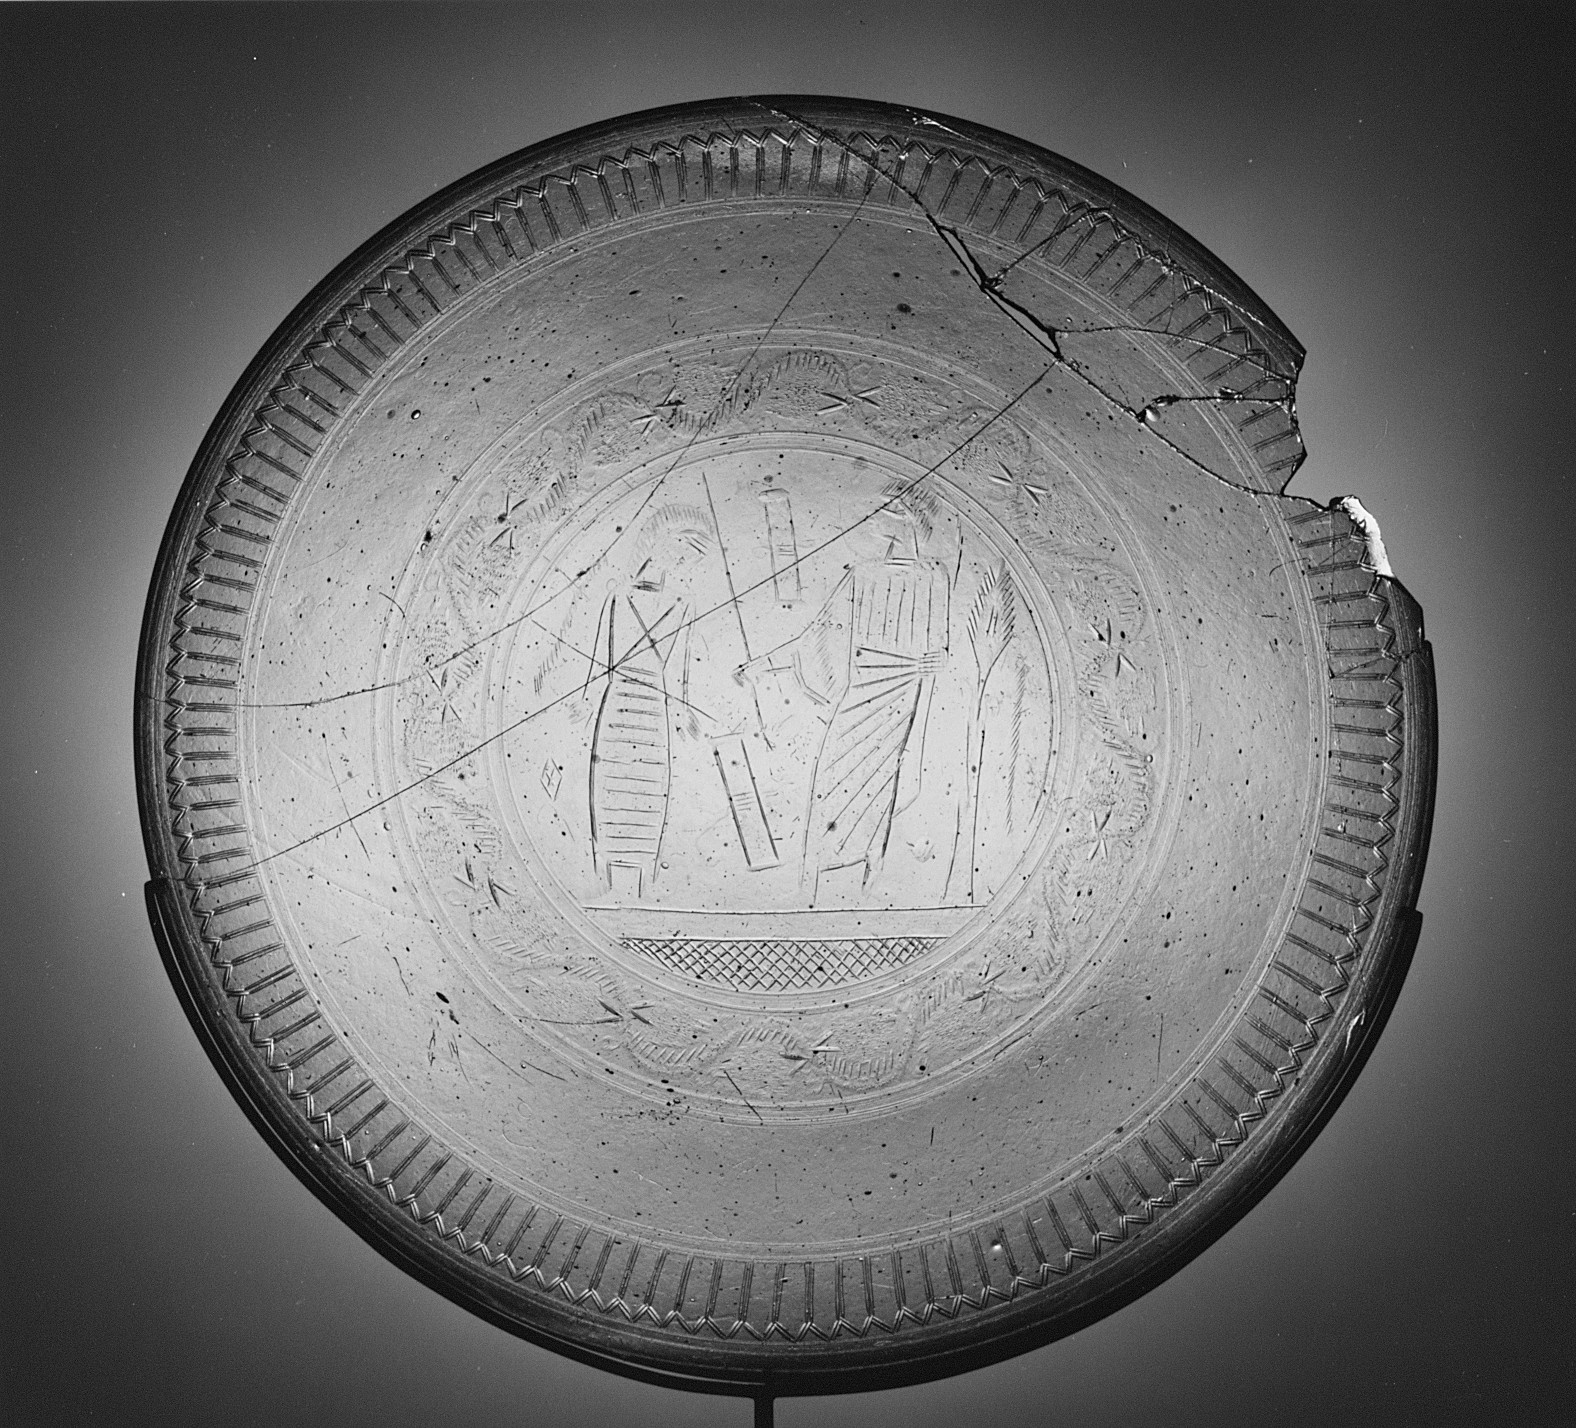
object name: dish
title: Glass Dish with an Engraving of the Raising of Lazarus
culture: roman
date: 301-500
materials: glass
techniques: engraving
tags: saints